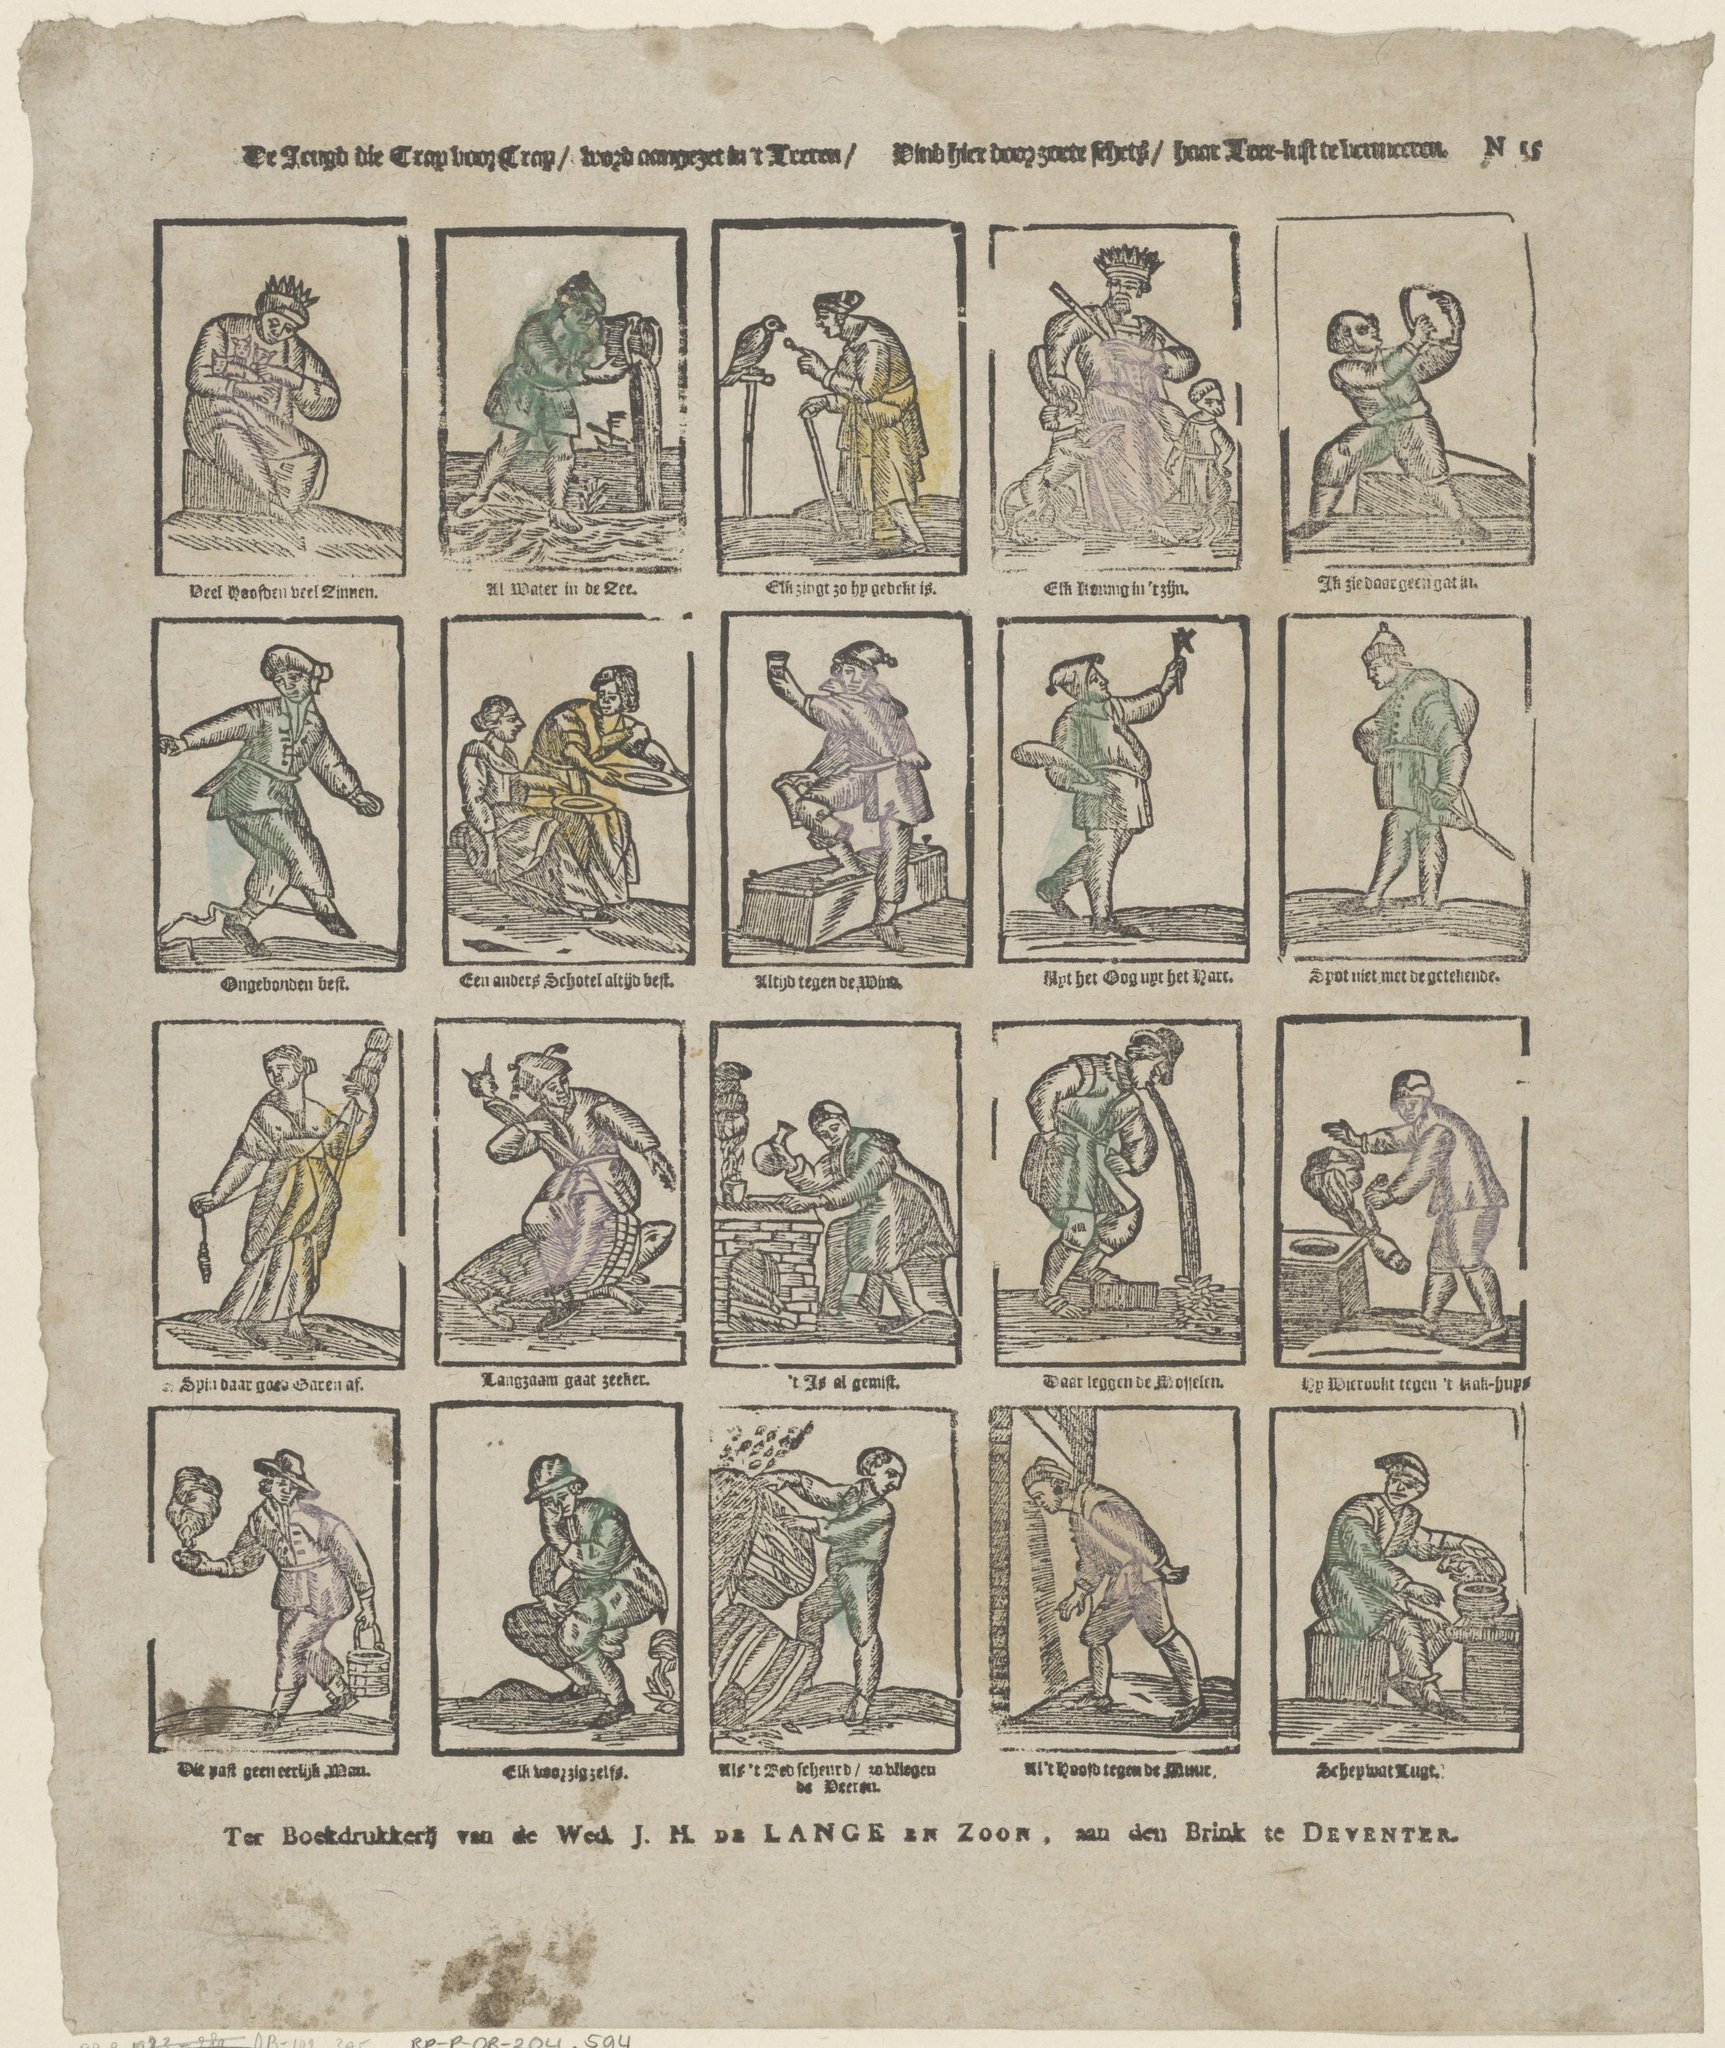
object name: popular print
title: De jeugd die trap voor trap / word aangezet in 't leeren / Vind hier door zoete schets / haar leer-lust te hernieuwen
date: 1787-1822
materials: paper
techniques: colour, letterpress printing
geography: deventer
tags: proverbs, sayings, etc.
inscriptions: collector's mark: Lugt 2760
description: Blad met 20 verbeeldingen van spreekwoorden. Onder elke afbeelding een onderschrift. Genummerd rechtsboven: N 15.